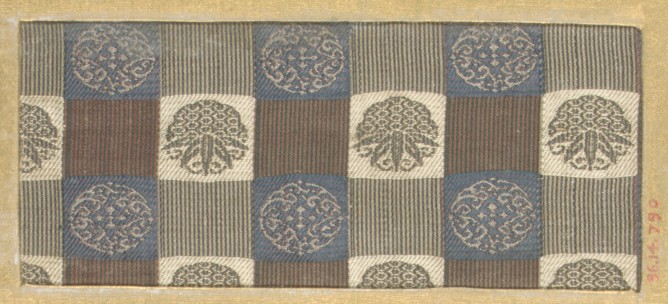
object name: piece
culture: japanese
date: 1701-1900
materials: silk